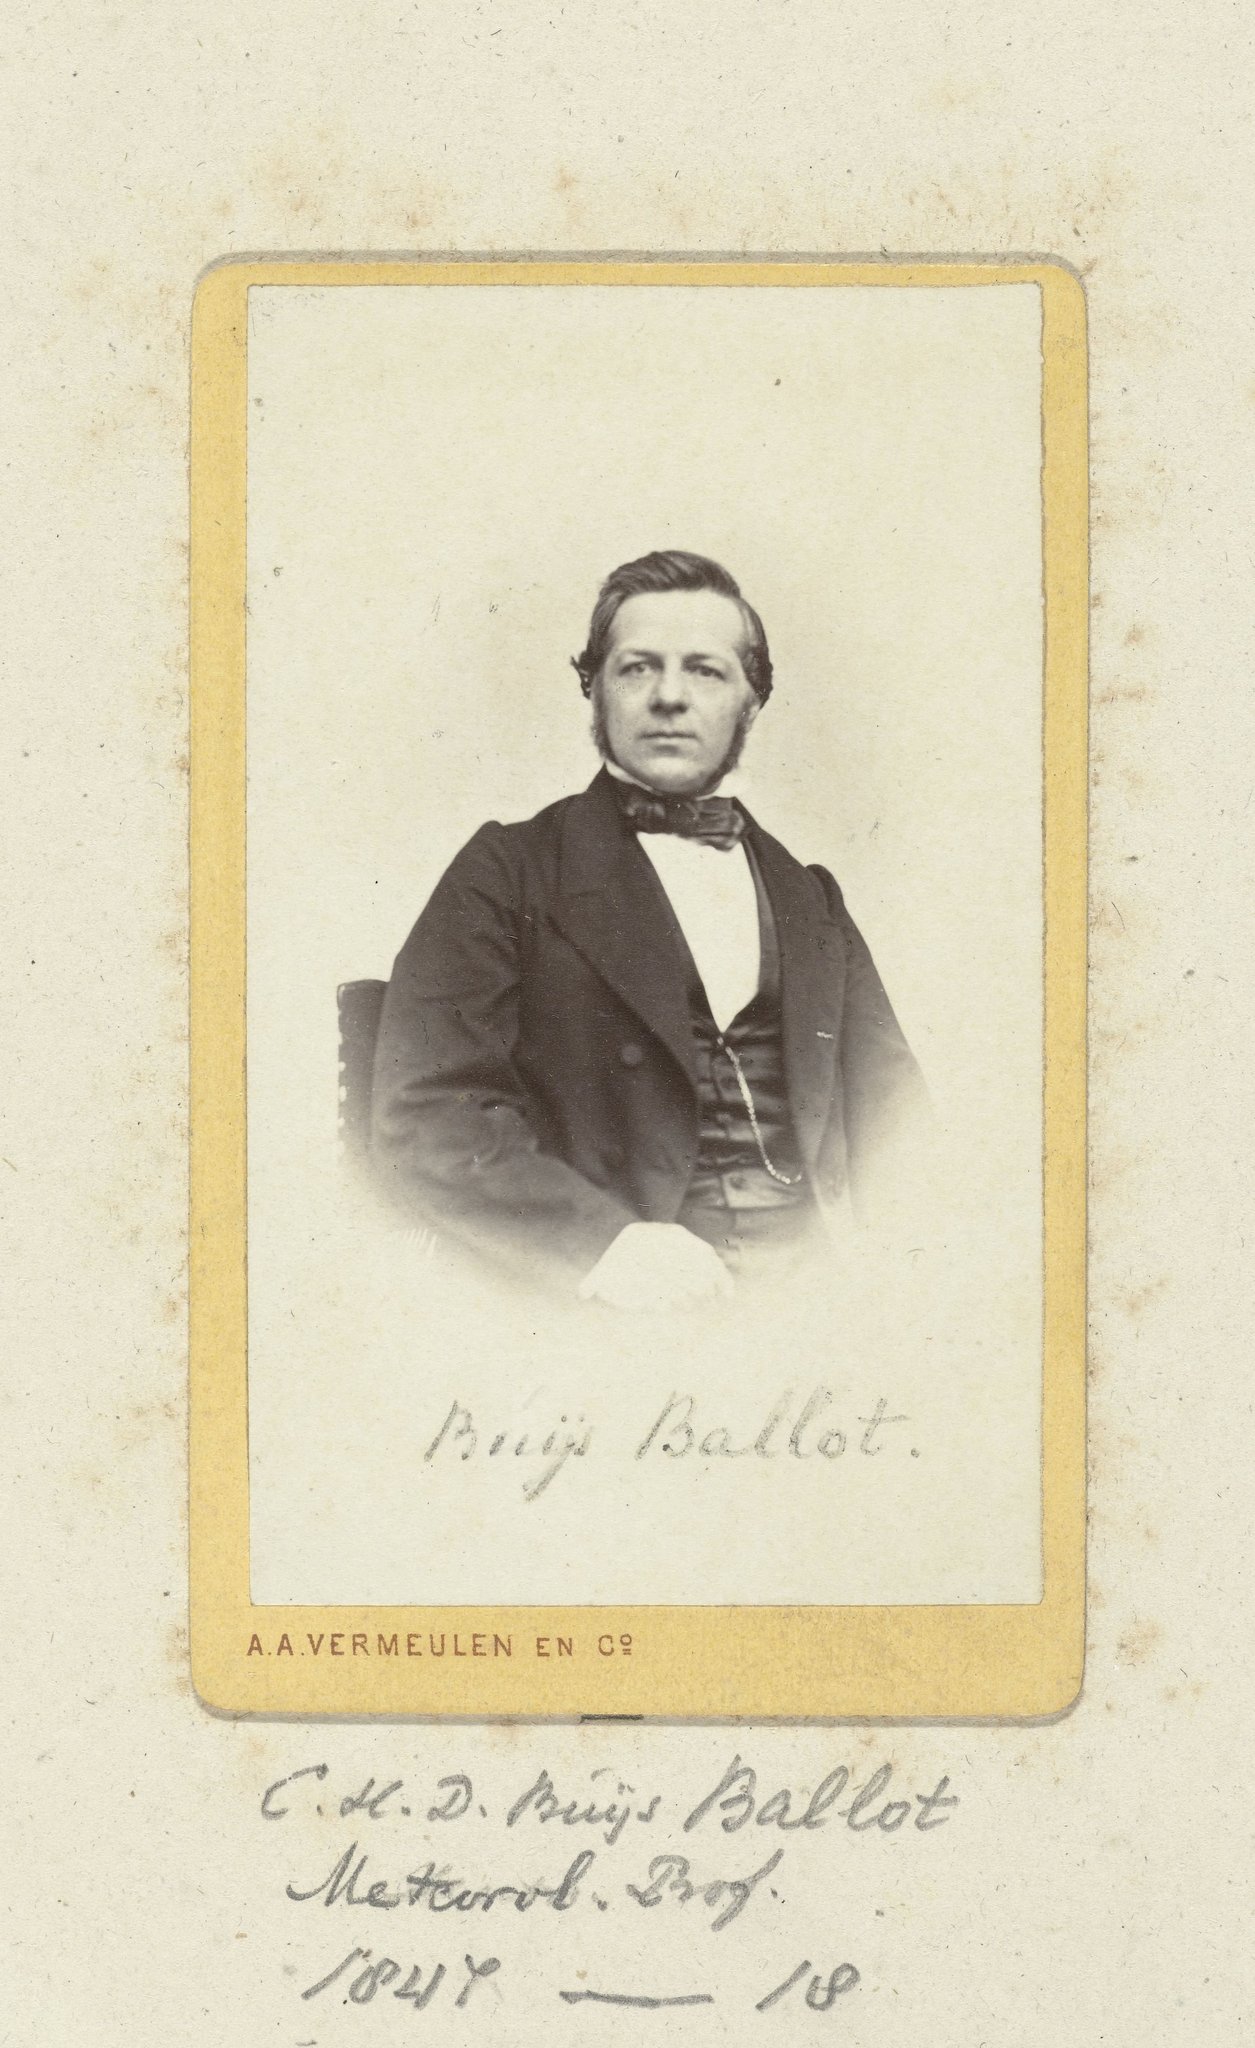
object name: carte de visite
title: Portret van C.H.D. Buys Ballot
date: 1860-1880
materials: paper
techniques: albumen print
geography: utrecht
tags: utrecht, physicist, historical persons (portraits and scenes from the life)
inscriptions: name: ‘C.H.D Buijs Ballot math. prof. 1847 - 18’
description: Hoogleraar in de faculteit Wis- en Natuurkunde aan de universiteit van Utrecht